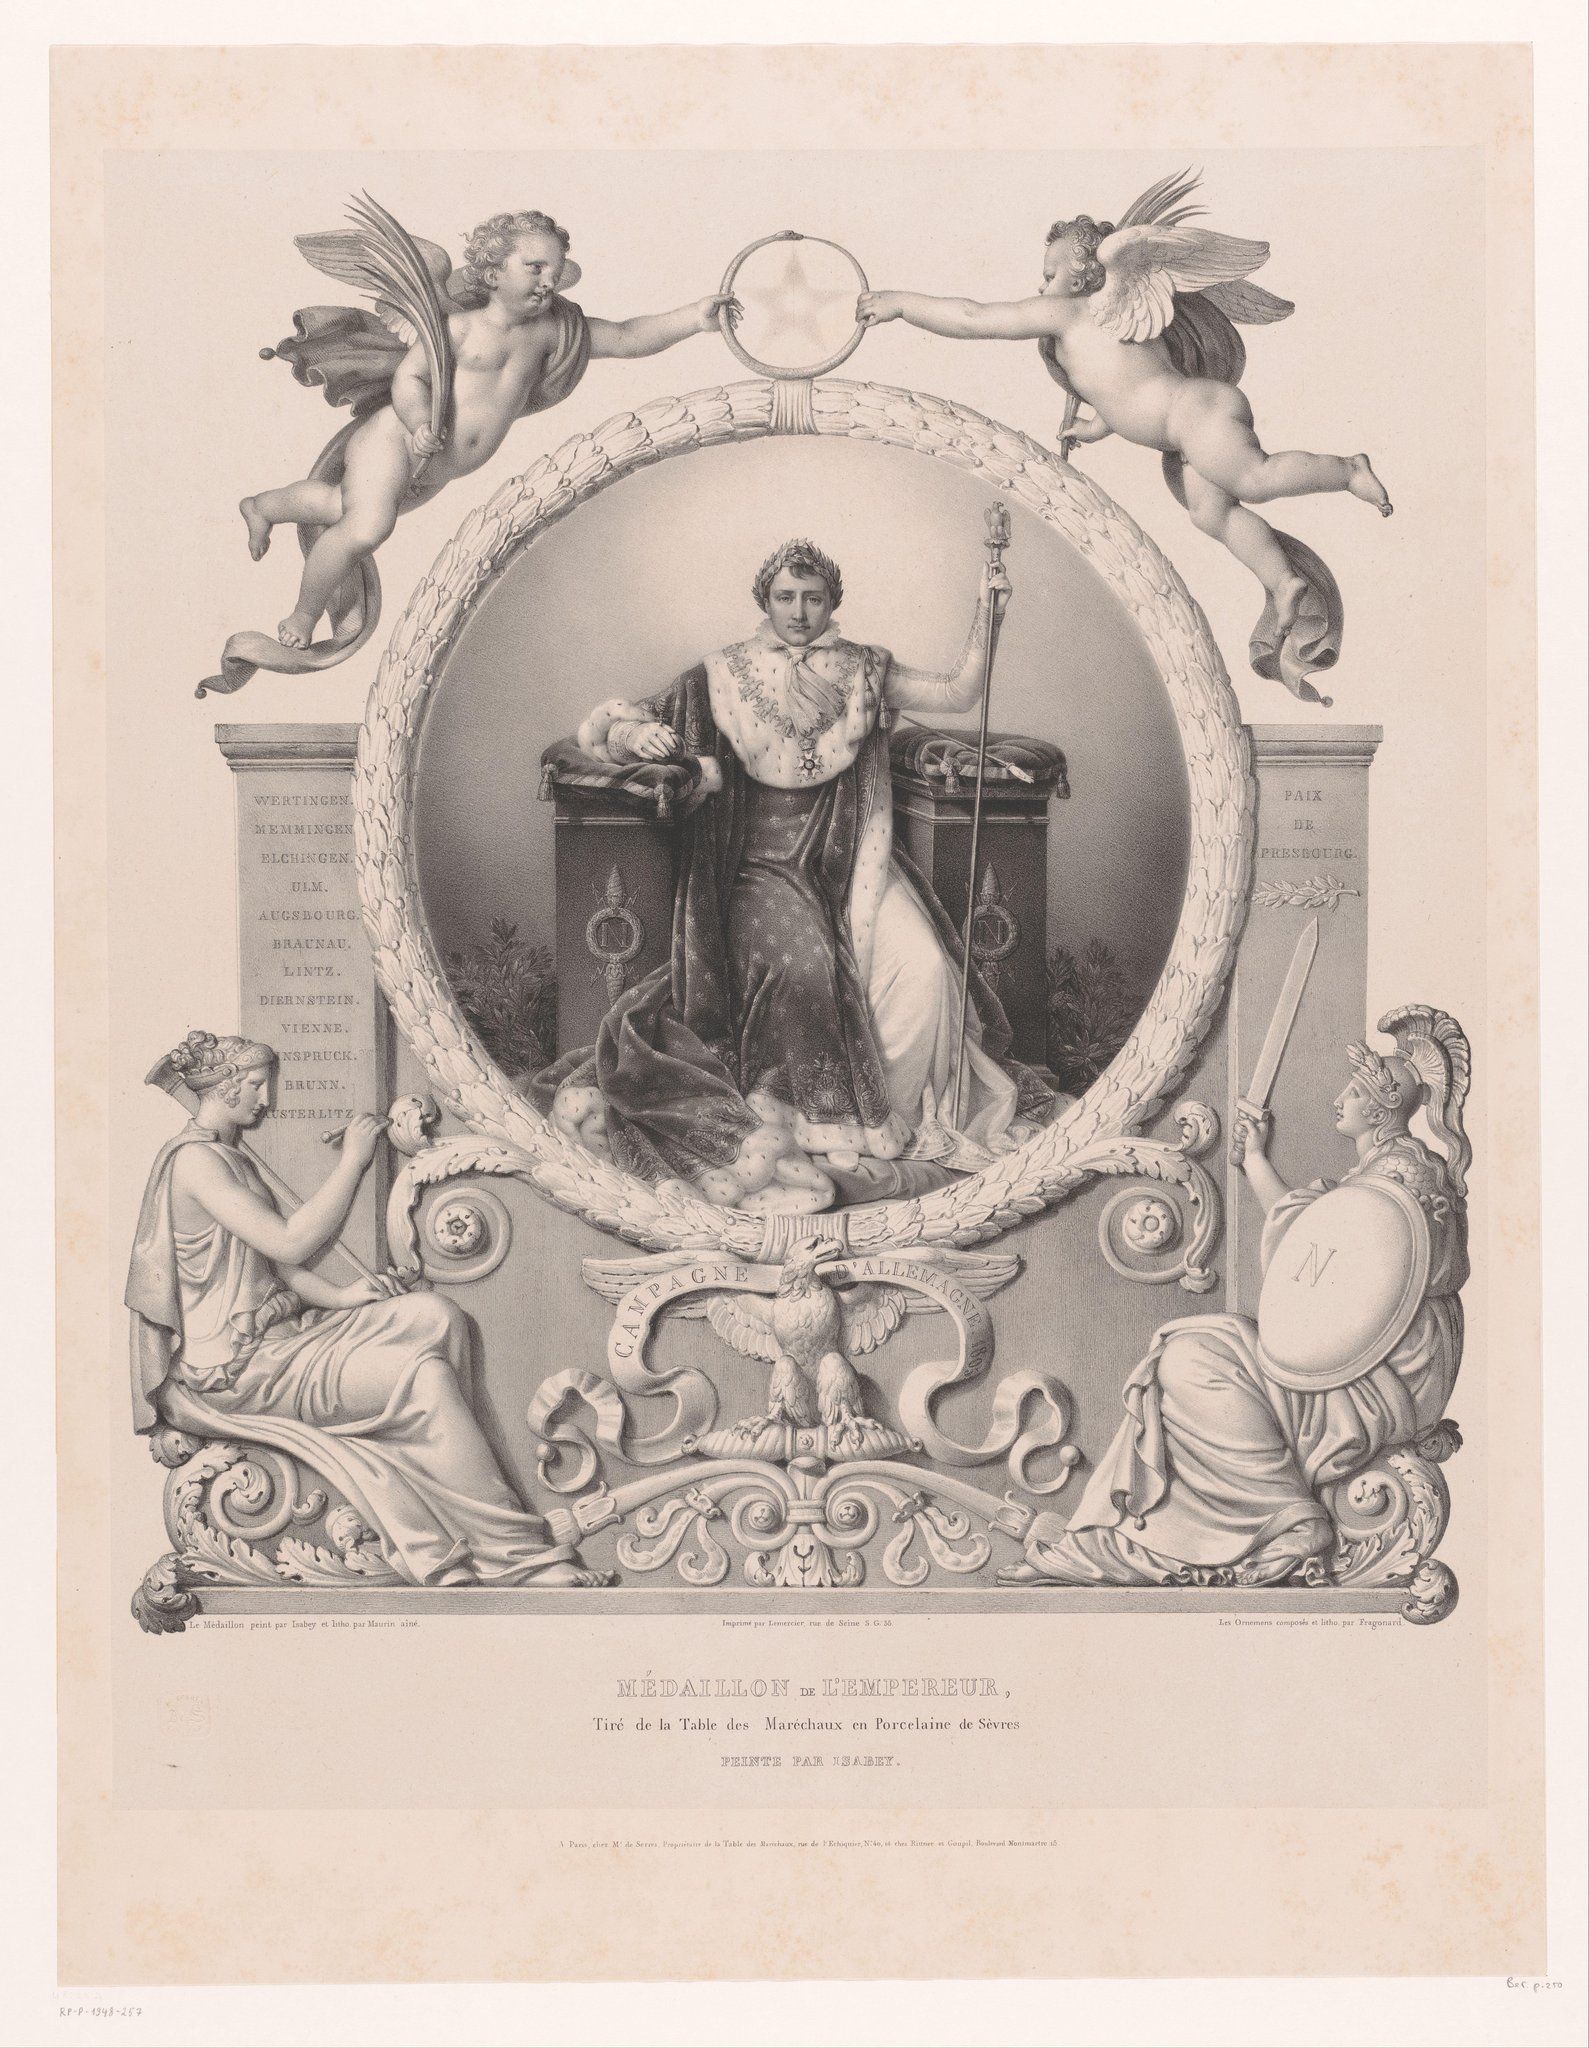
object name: print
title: Portret van Napoleon Bonaparte in een medaillon omringd door engelen en allegorische figuren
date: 1805-1860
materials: paper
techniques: lithograph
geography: paris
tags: napoleon i (emperor of the french), historical persons, emperor, angels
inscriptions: collector's mark: Lugt 2228, check stamp: ‘De Serre AS editeurs’